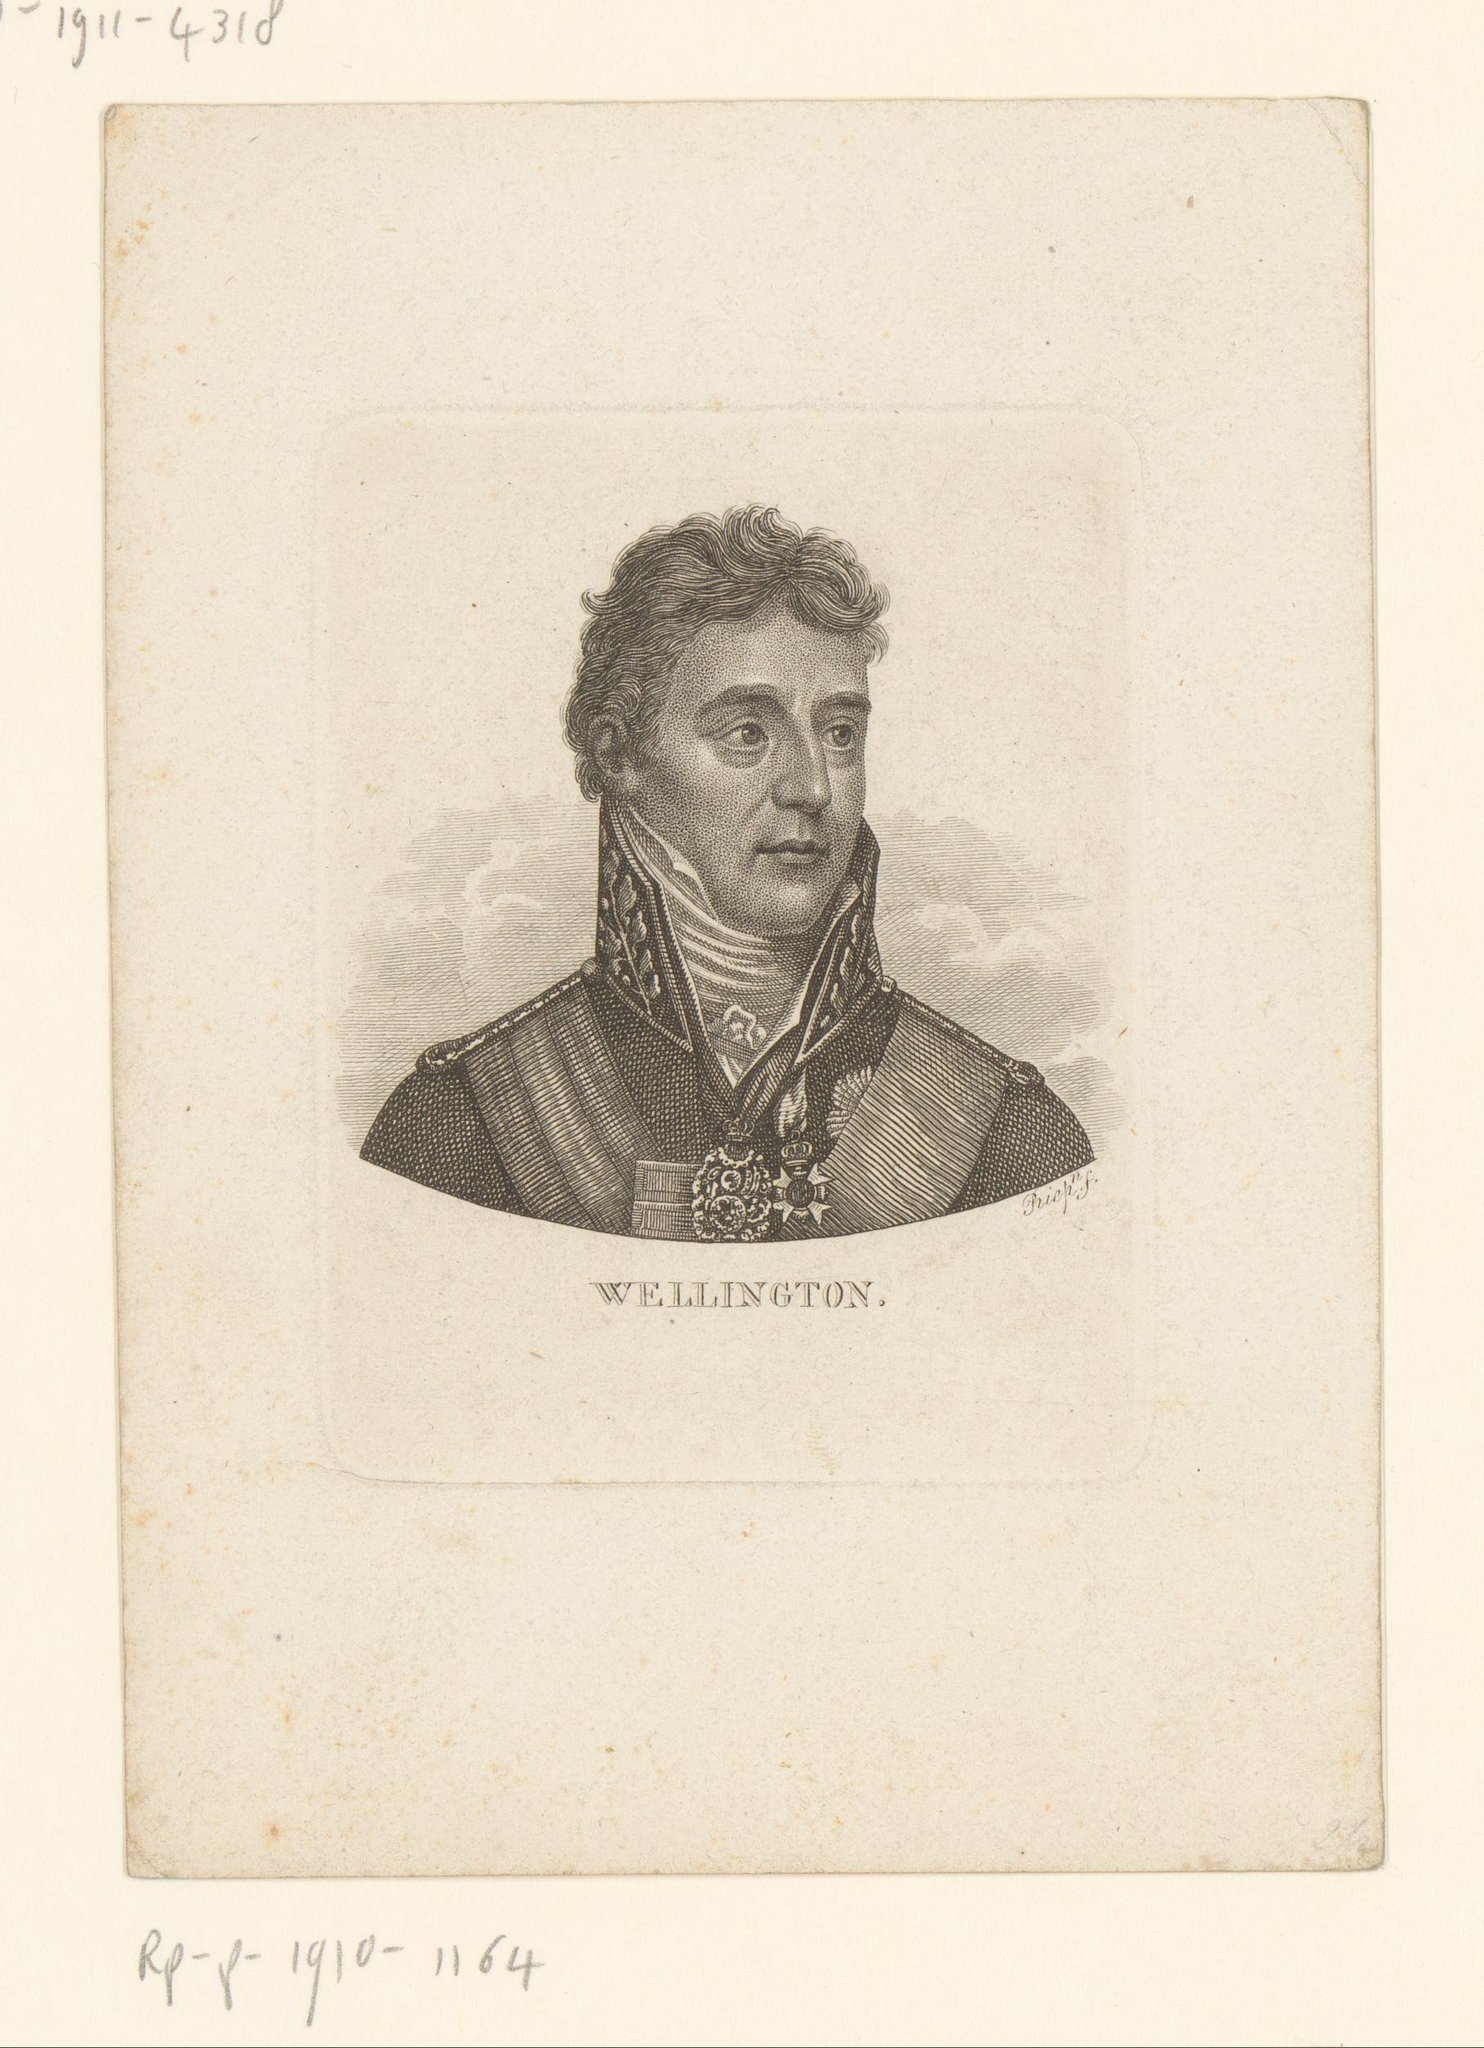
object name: print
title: Portret van Arthur Wellesley of Wellington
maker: ernst ludwig riepenhausen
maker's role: print maker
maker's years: 1765-1840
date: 1775-1840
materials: paper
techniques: engraving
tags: walmer castle, arthur wellesley of wellington, historical persons, medals and other marks of military honour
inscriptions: collector's mark: Lugt 2228